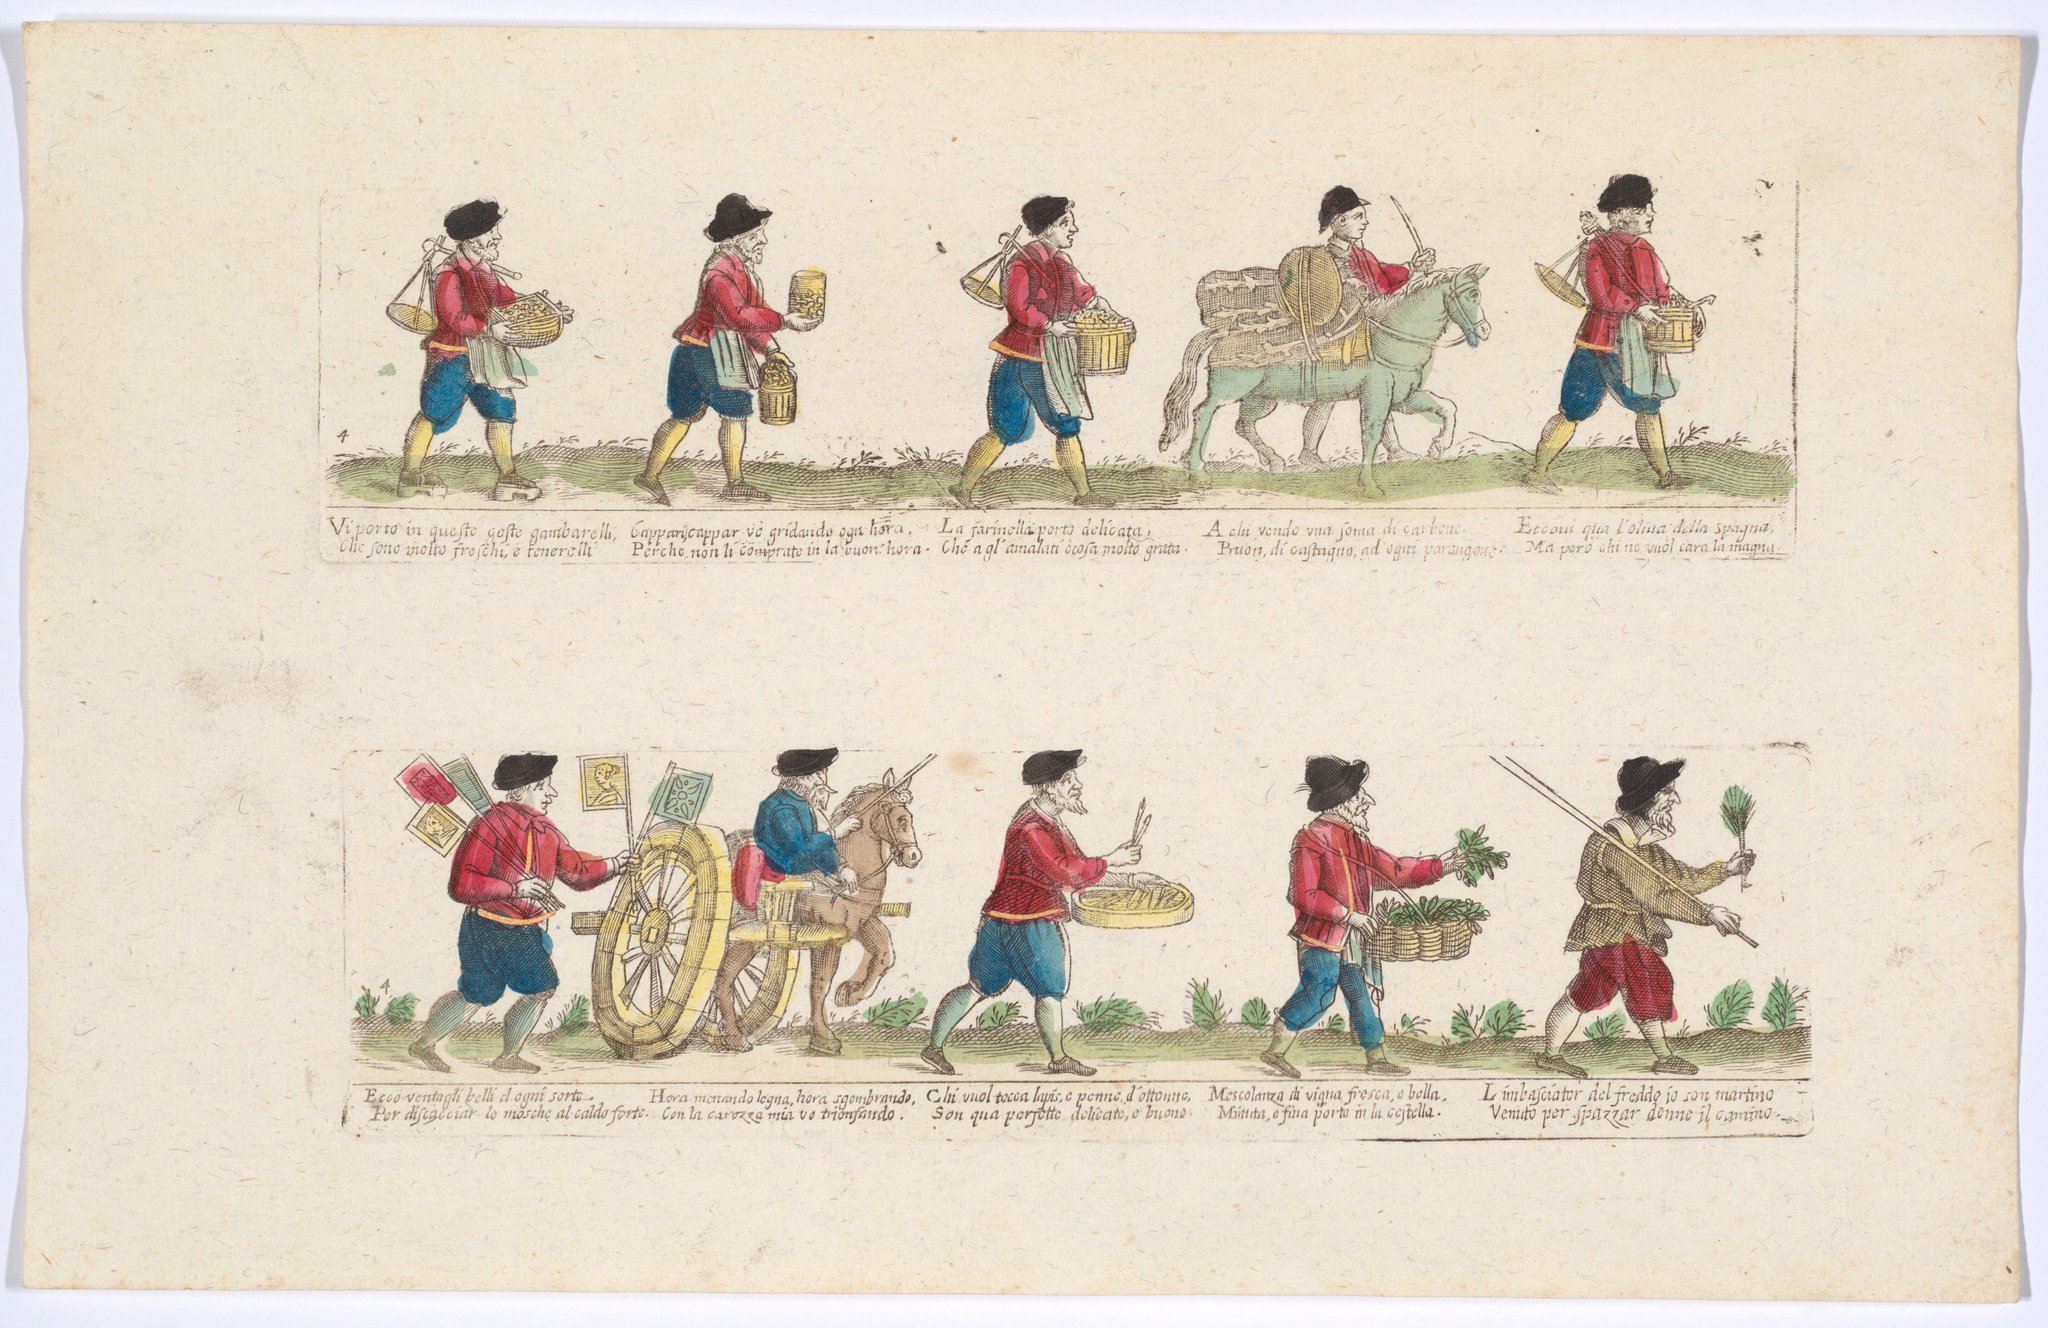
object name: print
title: Plate 4 depicting the trades of Rome, here including vendors of shrimps, Spanish olives, herbs etc, from the 'Descrición de las artes que se llaman para los calles de la ciudad de Roma'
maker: remondini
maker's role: publisher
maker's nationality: italian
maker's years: 1650-1860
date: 1770-1800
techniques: engraving, hand coloring